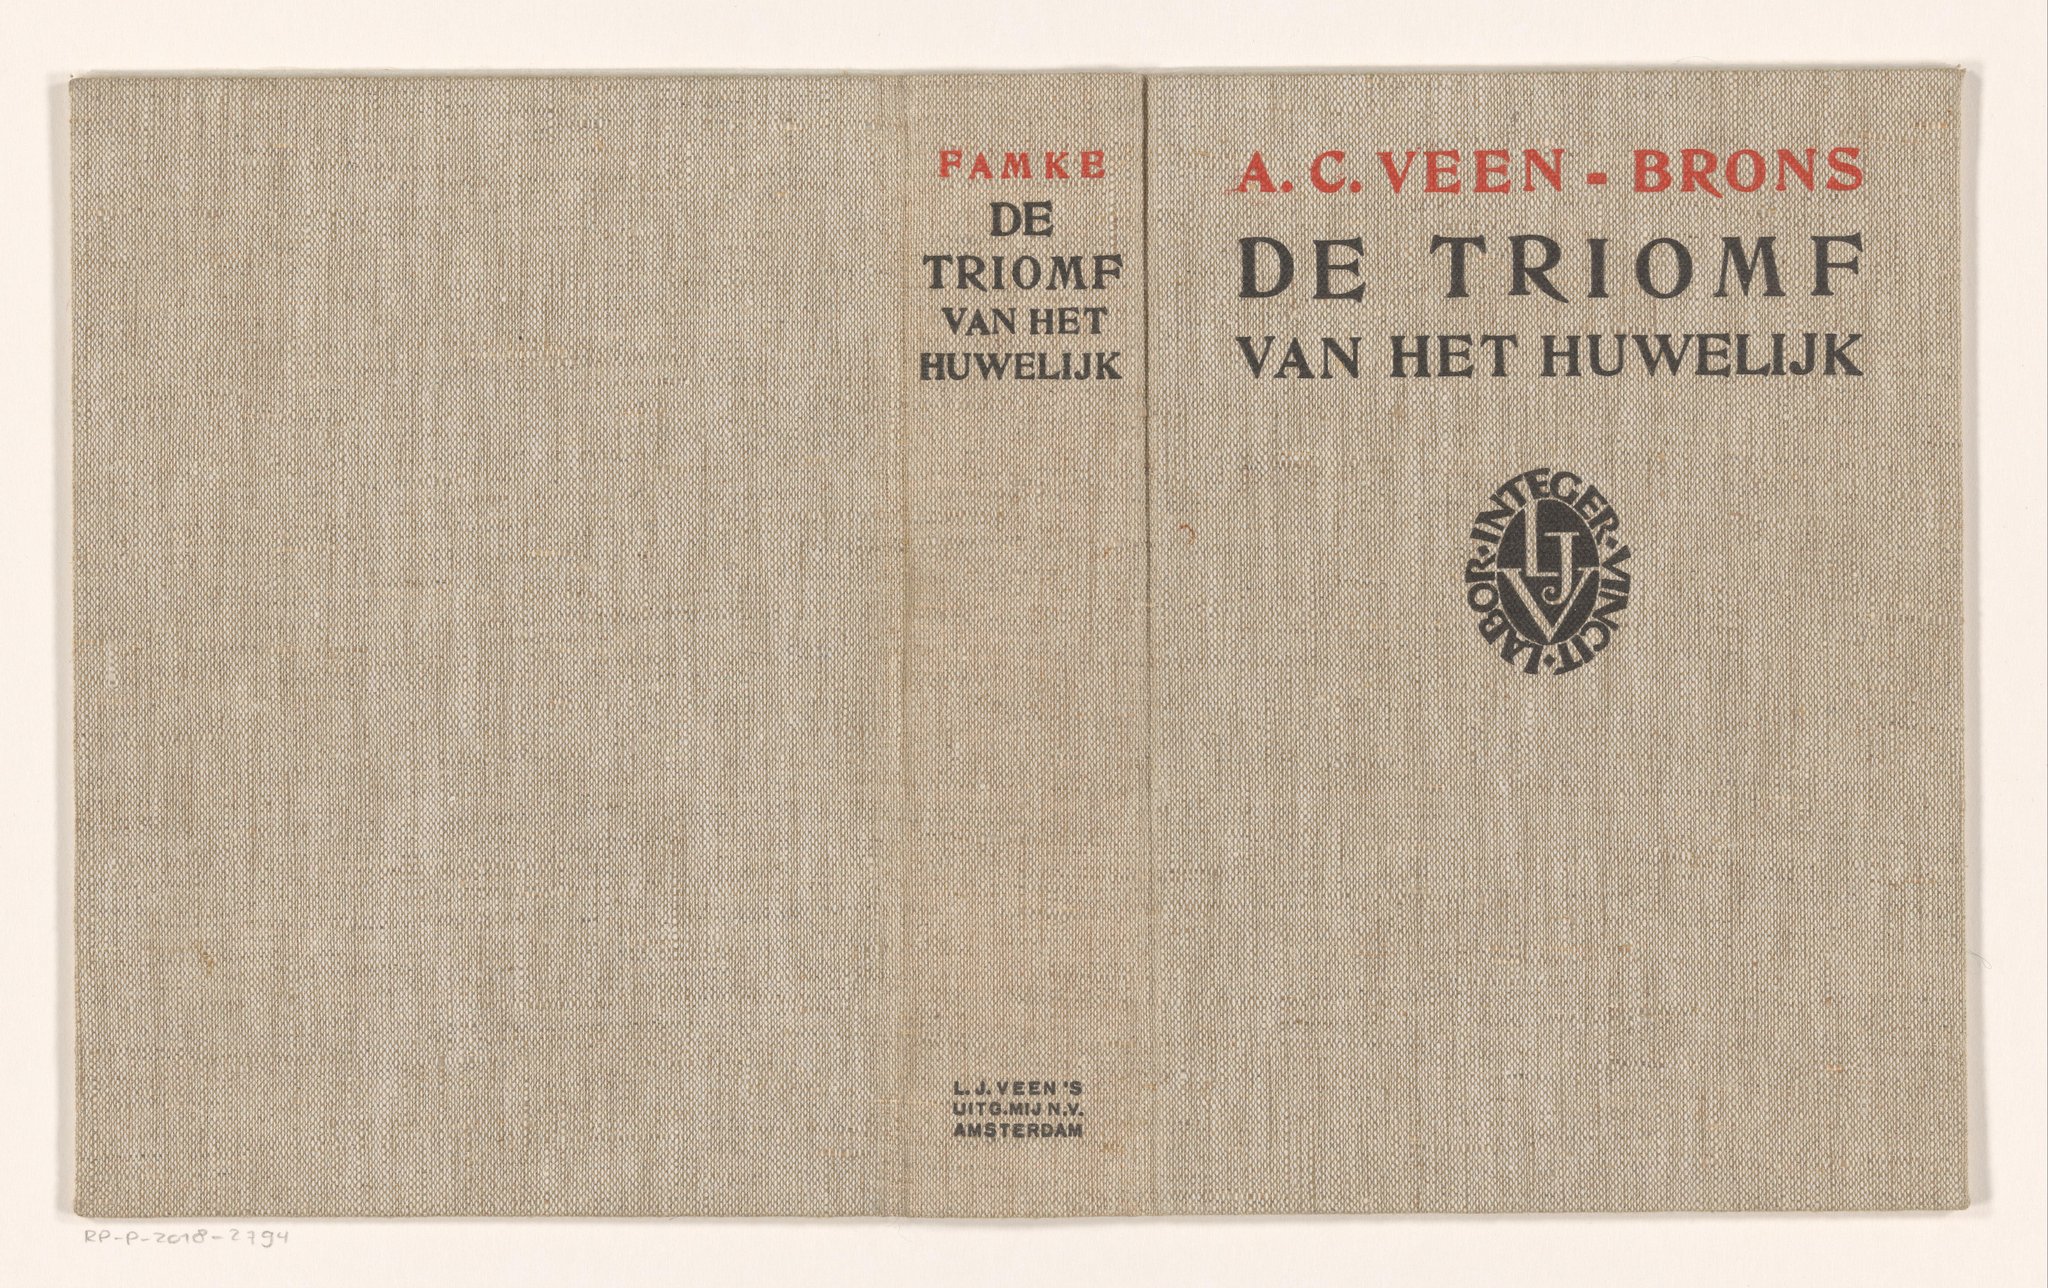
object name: binding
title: Boekband voor: A.C. Veen-Brons (Famke), De triomf van het huwelijk. De nieuwe richting in de Nederlandsche vrouwenbeweging, 1931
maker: Anonymous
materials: cardboard, linen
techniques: printing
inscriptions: collector's mark: Lugt 2228a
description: Auteursnaam, boektitel en vignet van uitgeversmaatschappij L.J. Veen.